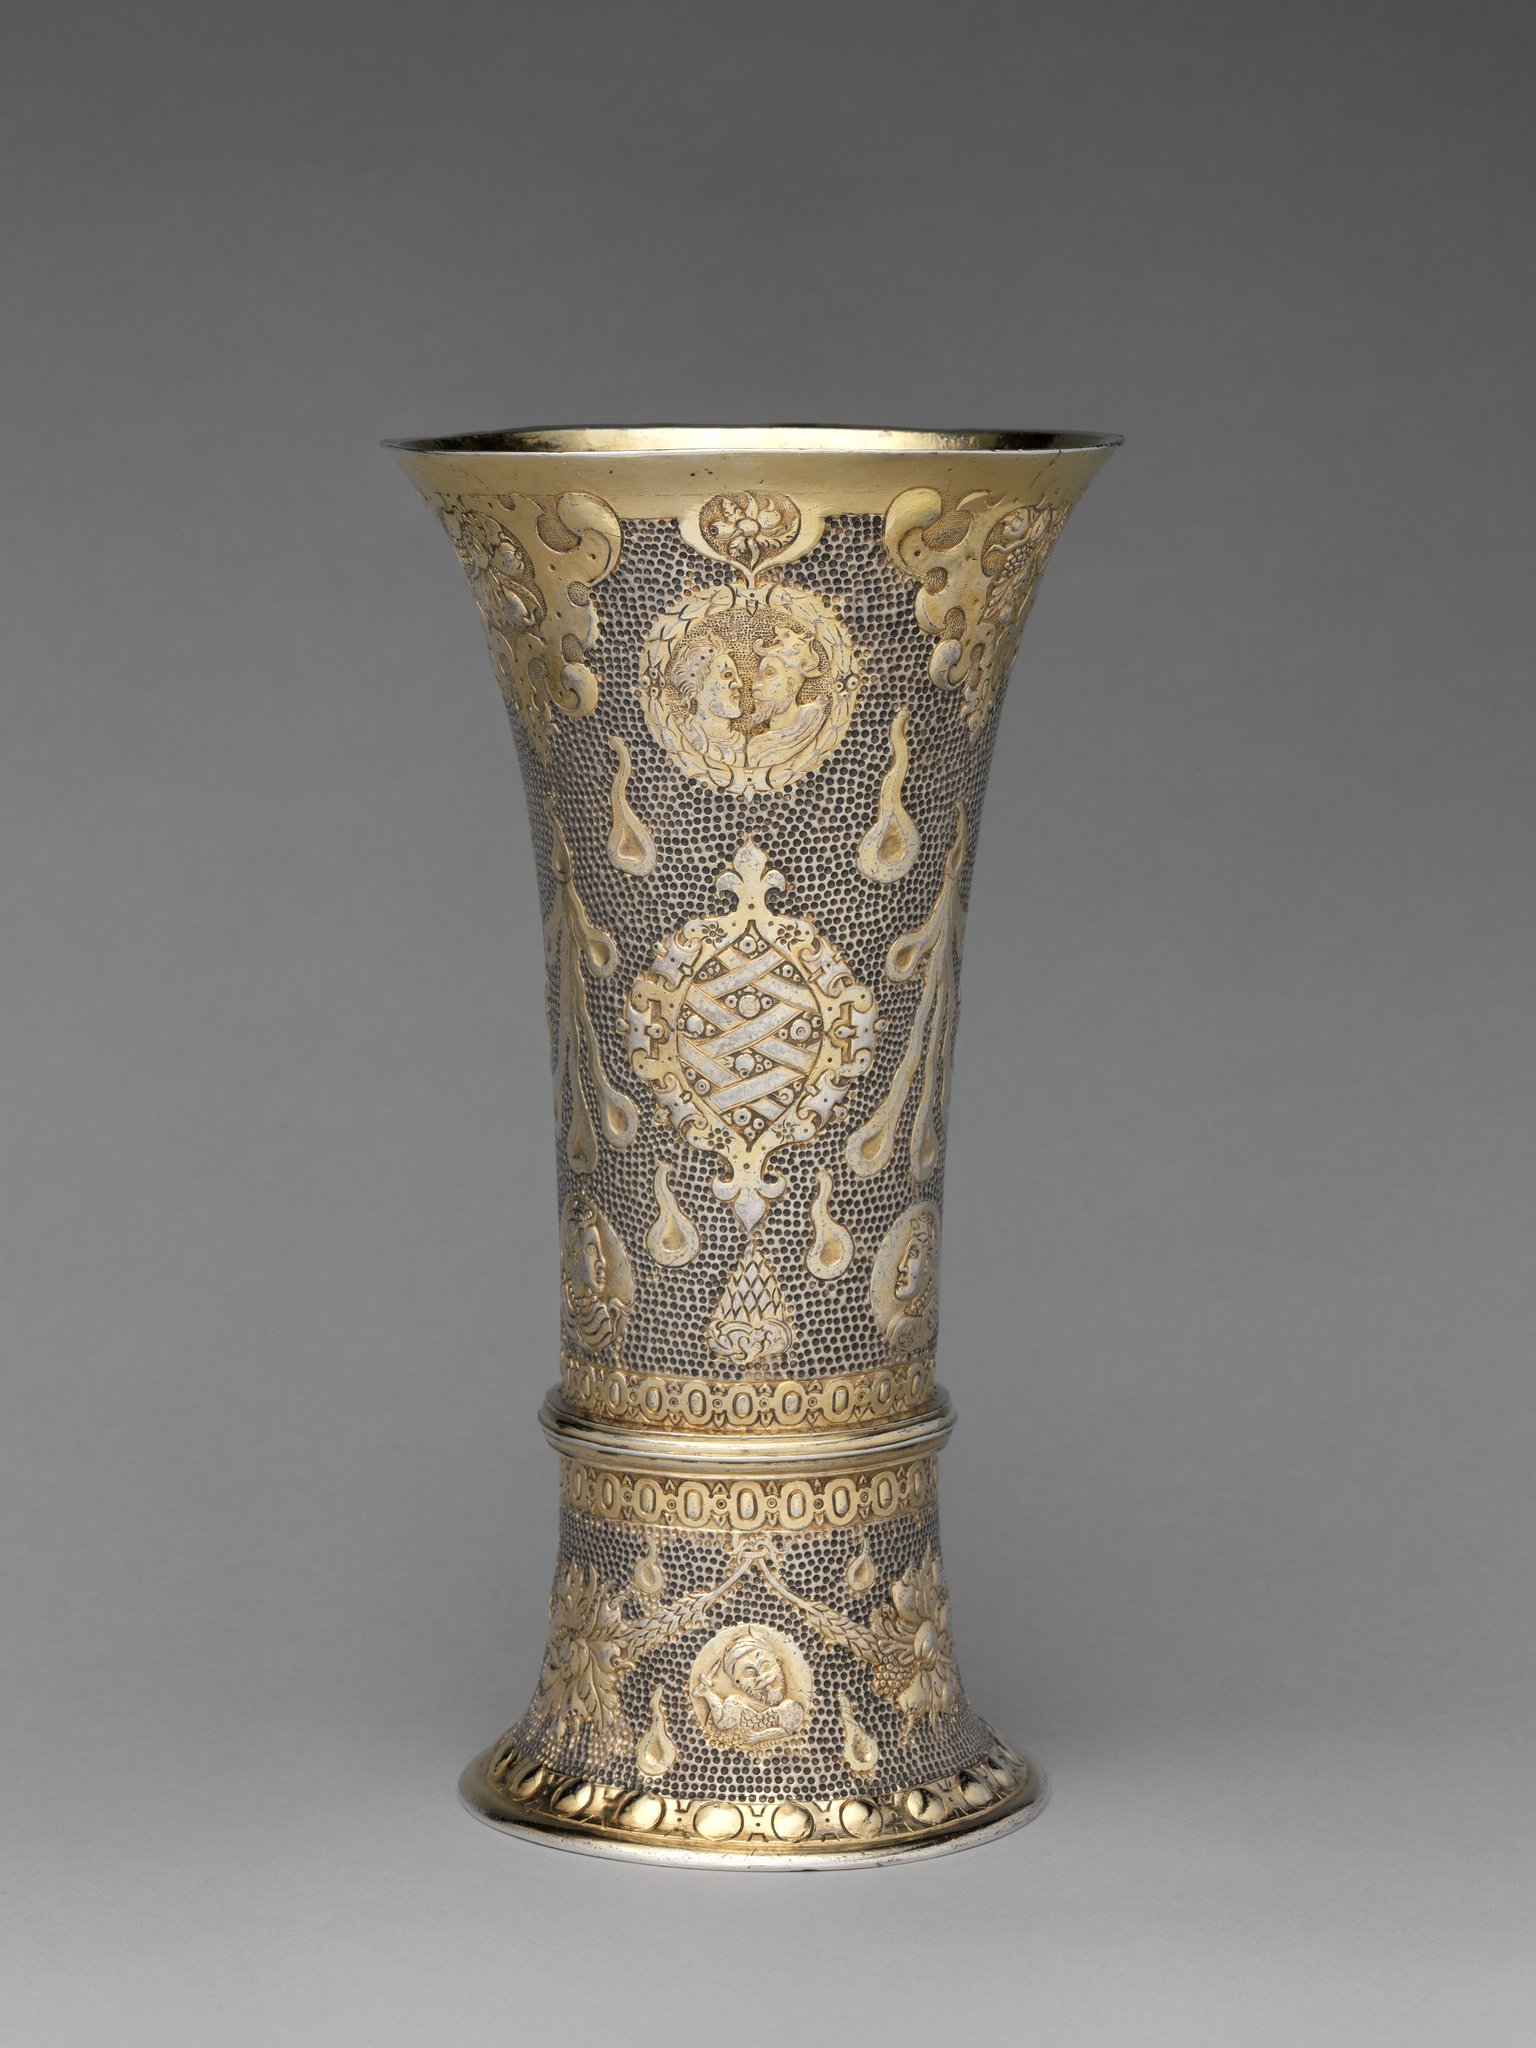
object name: beaker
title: Footed beaker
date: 1567-1600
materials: silver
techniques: gilding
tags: men,portraits,profiles